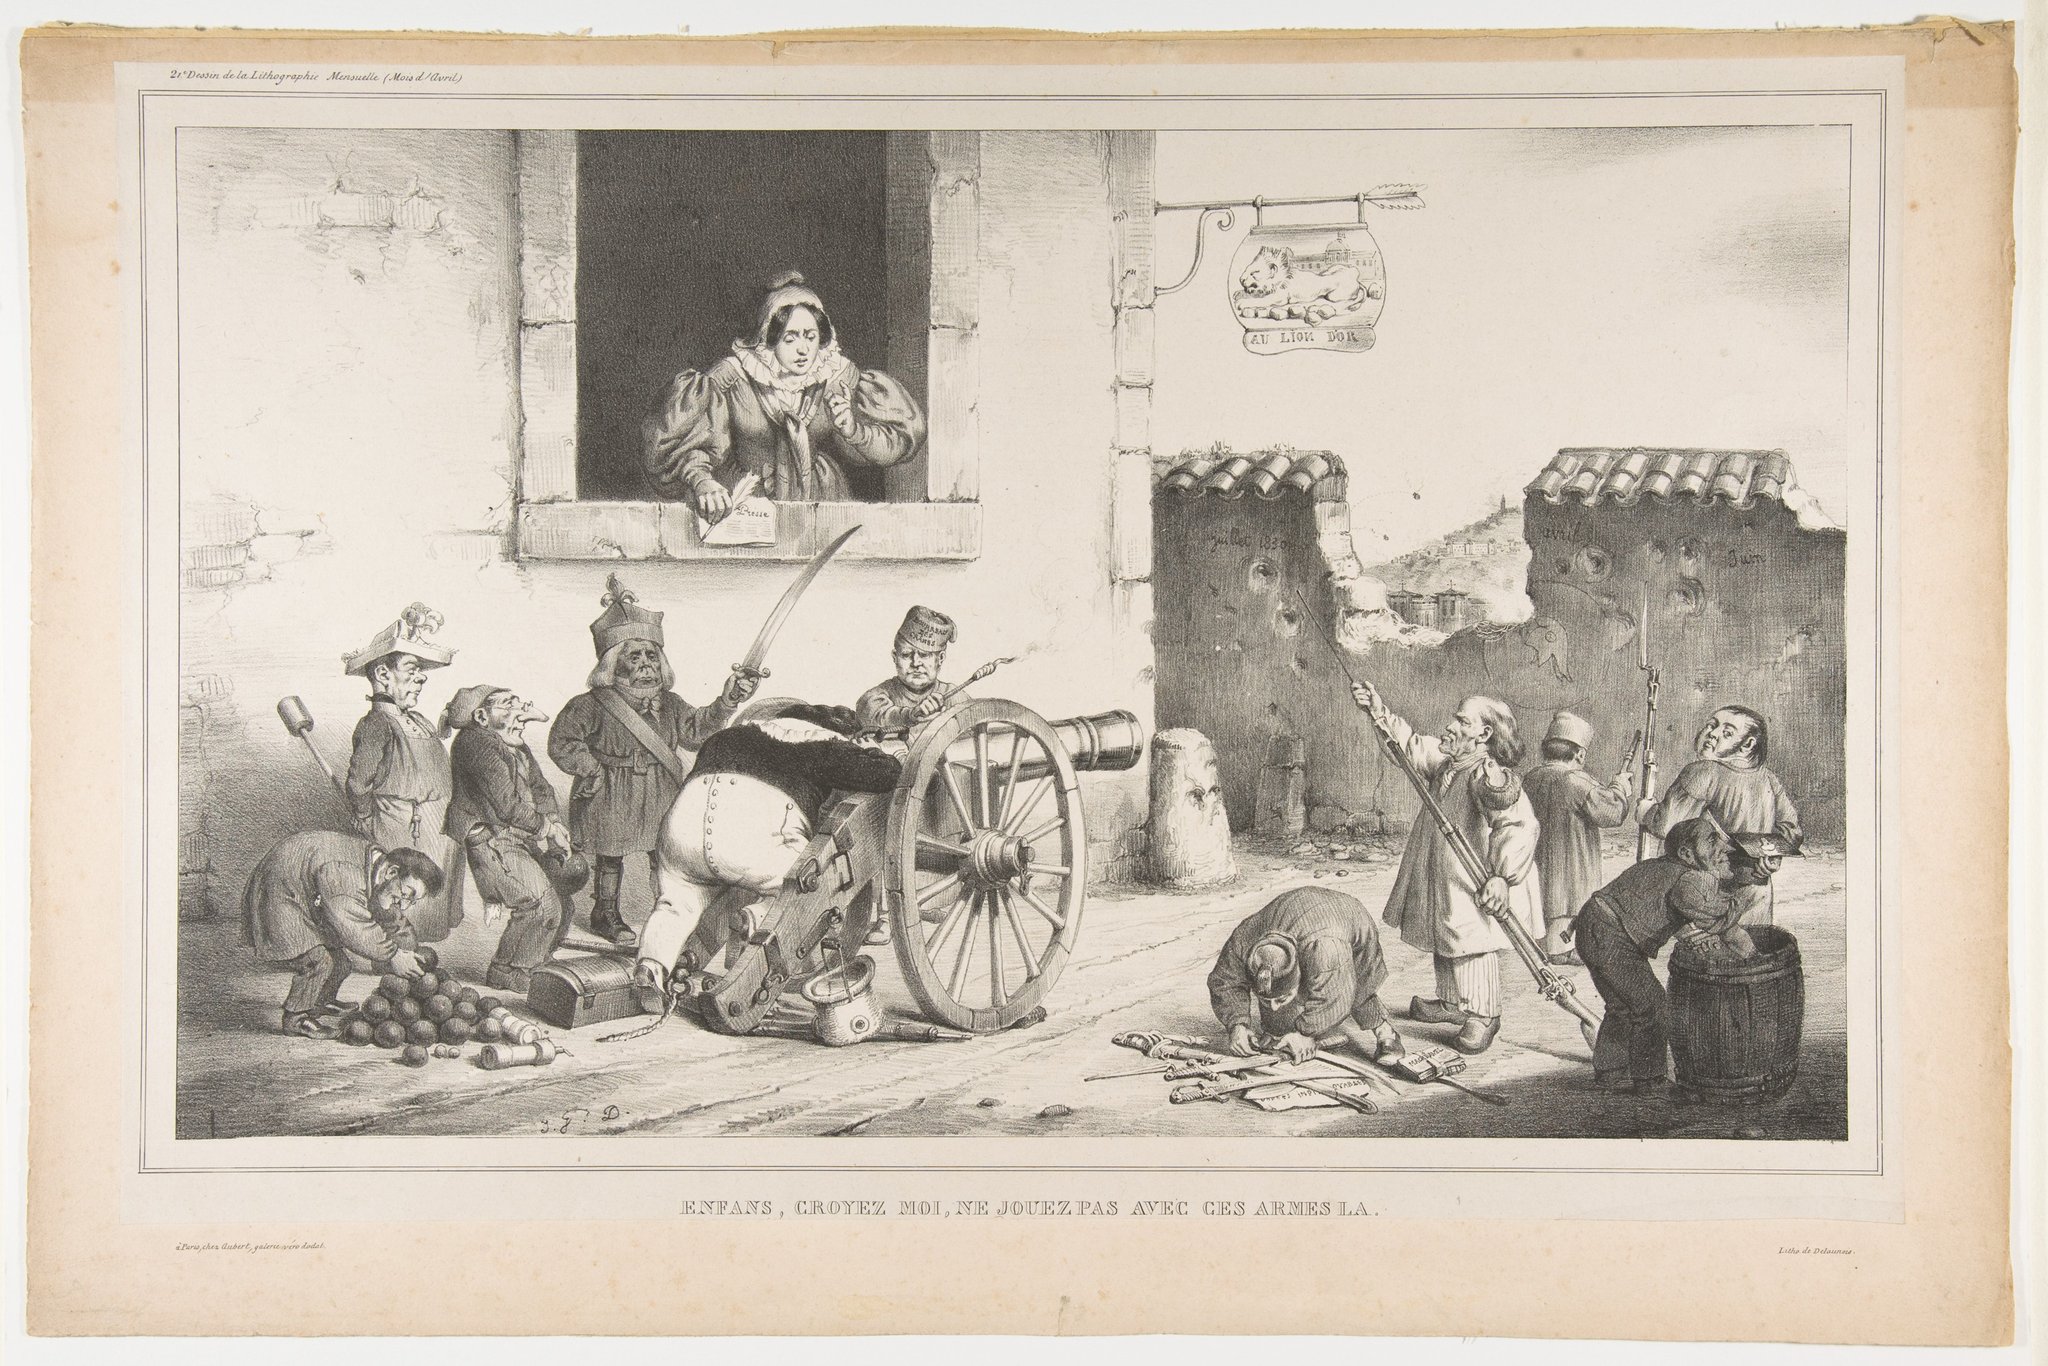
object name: print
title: Children, Obey Me, Do Not Play With Those Weapons, from "L'Association Mensuelle no. 21"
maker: j. j. grandville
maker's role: artist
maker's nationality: french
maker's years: 1803-1847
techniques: lithograph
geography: paris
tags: cannons,swords,men,women